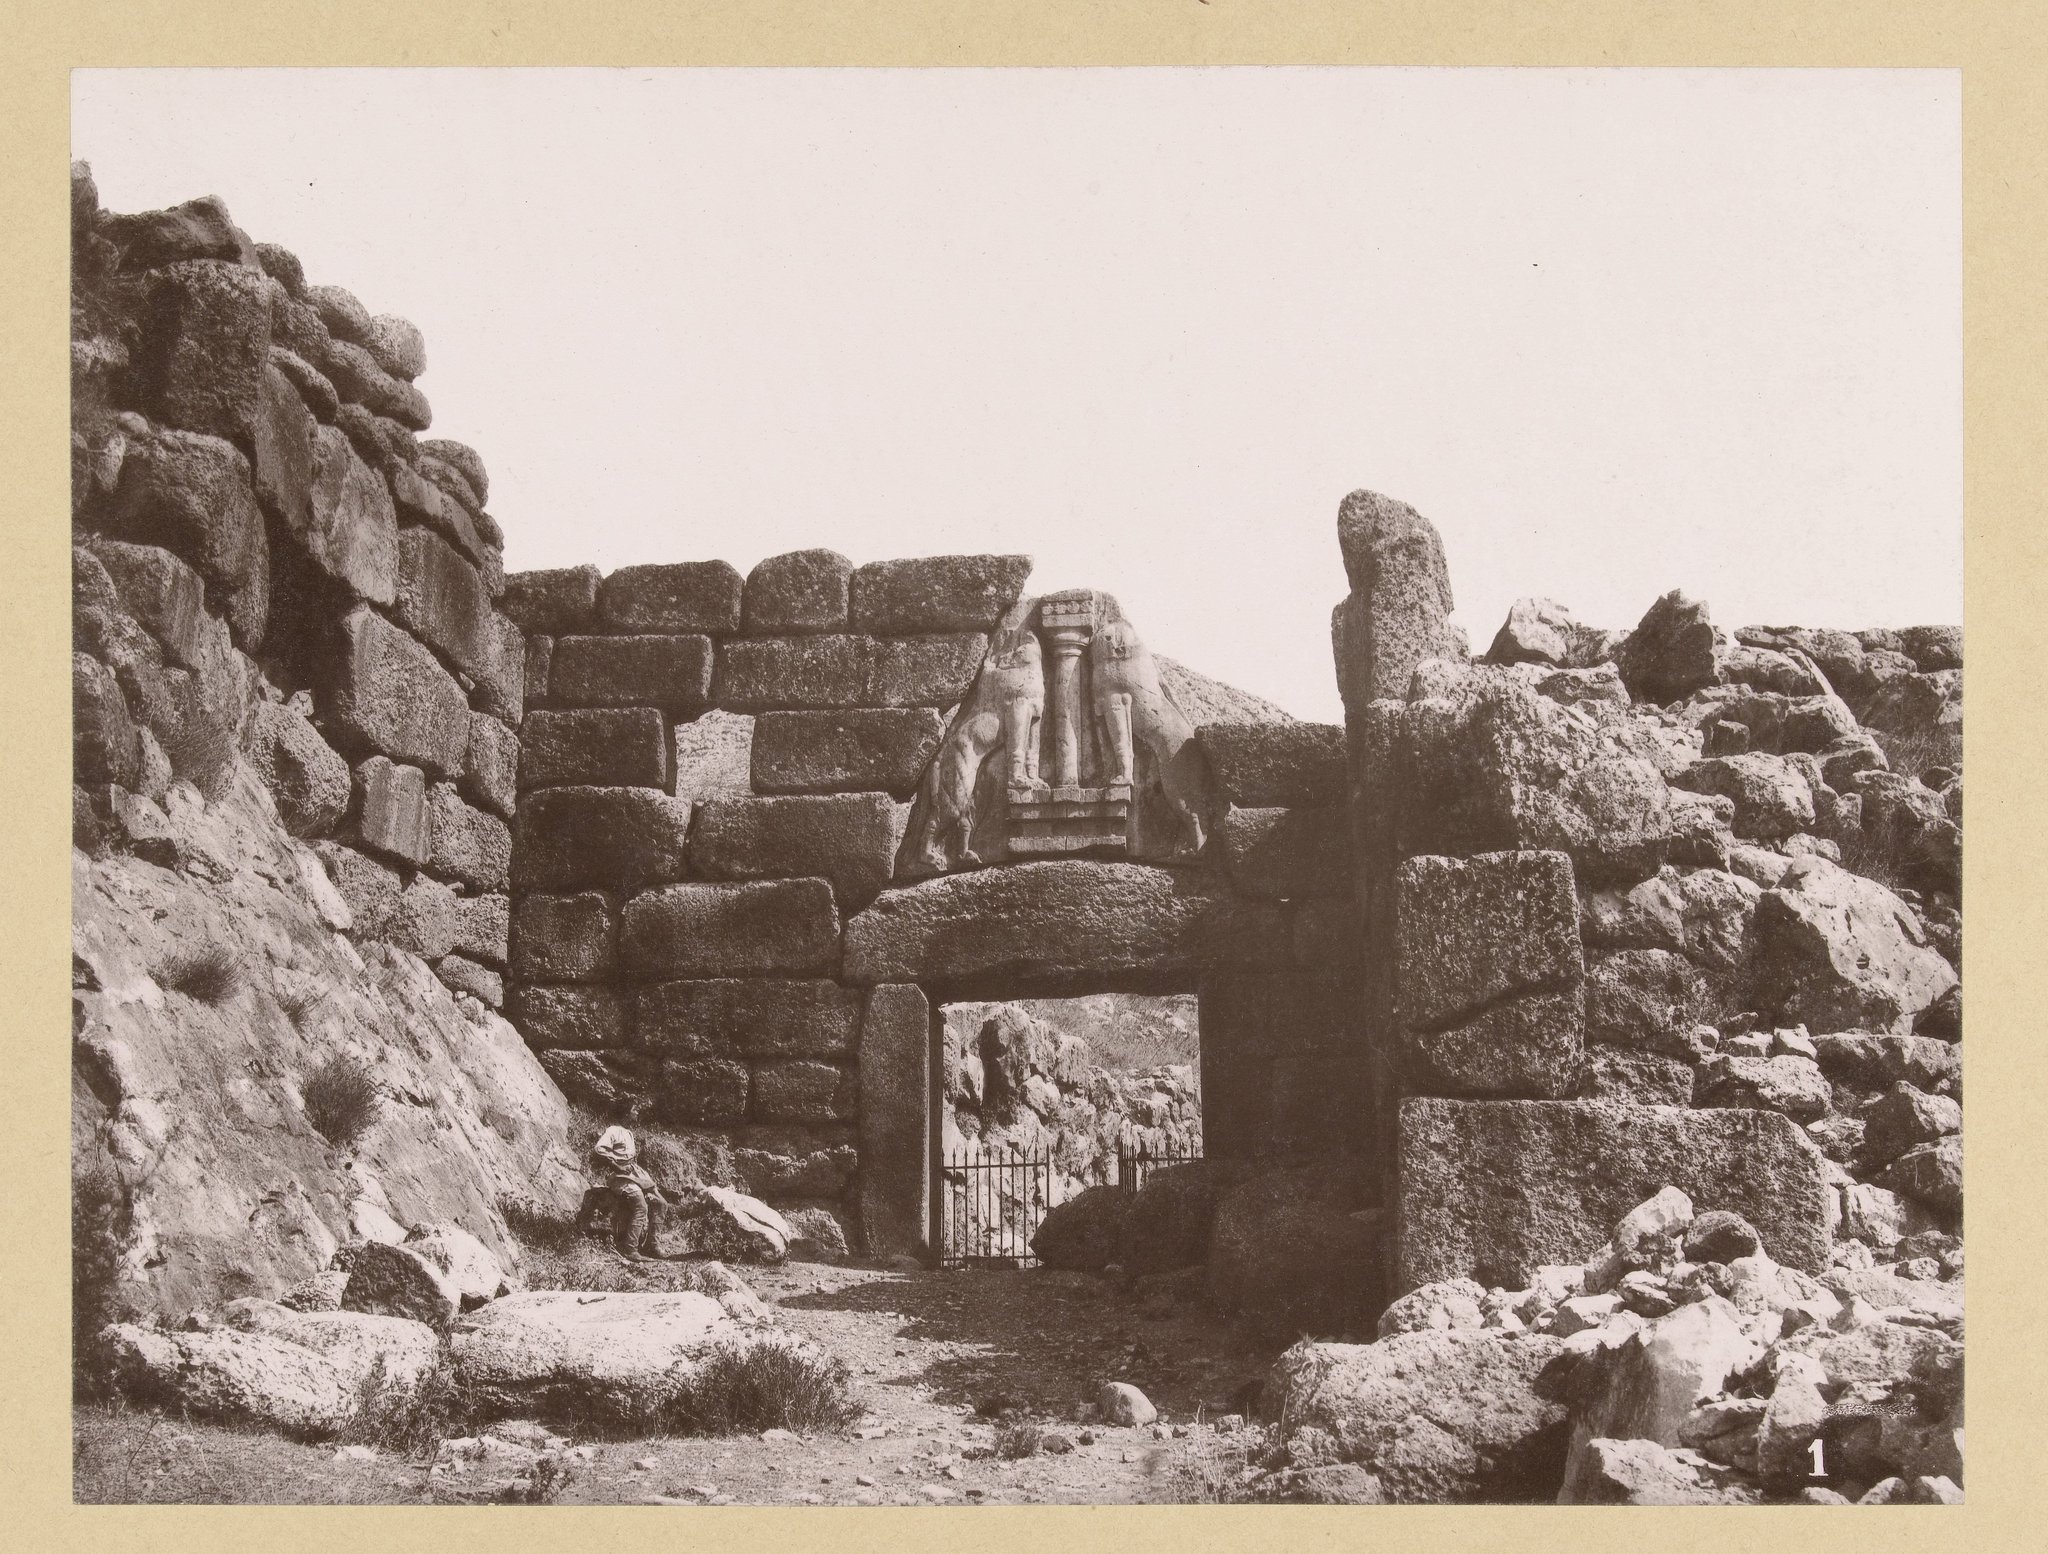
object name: photomechanical print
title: Leeuwenpoort van Mycene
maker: Anonymous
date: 1890-1895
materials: cardboard, paper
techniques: photograph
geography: mycene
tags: gate, entrance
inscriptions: stamp: ‘Gemeentelijke bibliotheek/ Rotterdam’, number: ‘1’, check stamp: ‘Bristol/ L.M.’, title: ‘G 48. De leeuwenpoort van Mycenae.’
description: Onderdeel van een groep door fotograaf Richard Polak op reis verzamelde foto’s. Deze fotomechanische afdruk is samen met andere op zijn reizen verzamelde foto's tentoongesteld bij de Rotterdamsche Kunstkring (1895), Arti en Amicitiae te Amsterdam (1897-1898?) en Societeit 't Collegie te Kampen (datum vooralsnog onbekend).